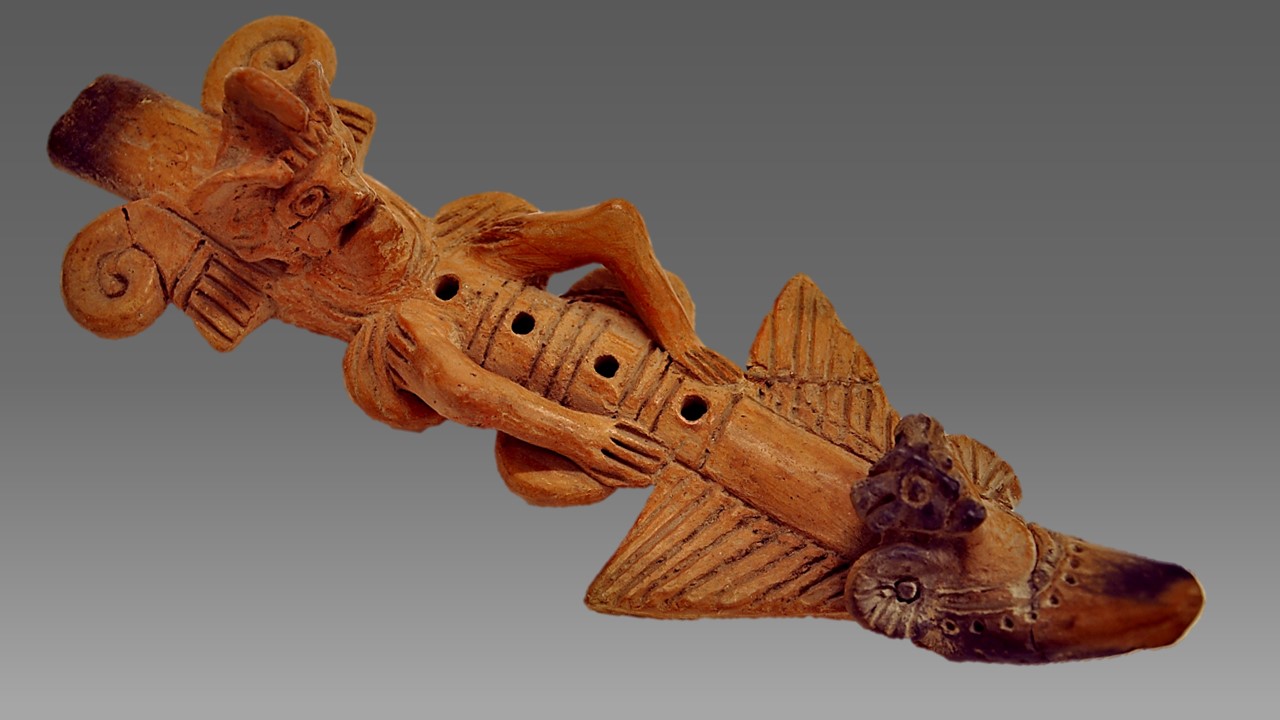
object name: pottery flute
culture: mexican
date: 1801-1900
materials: clay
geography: mexico